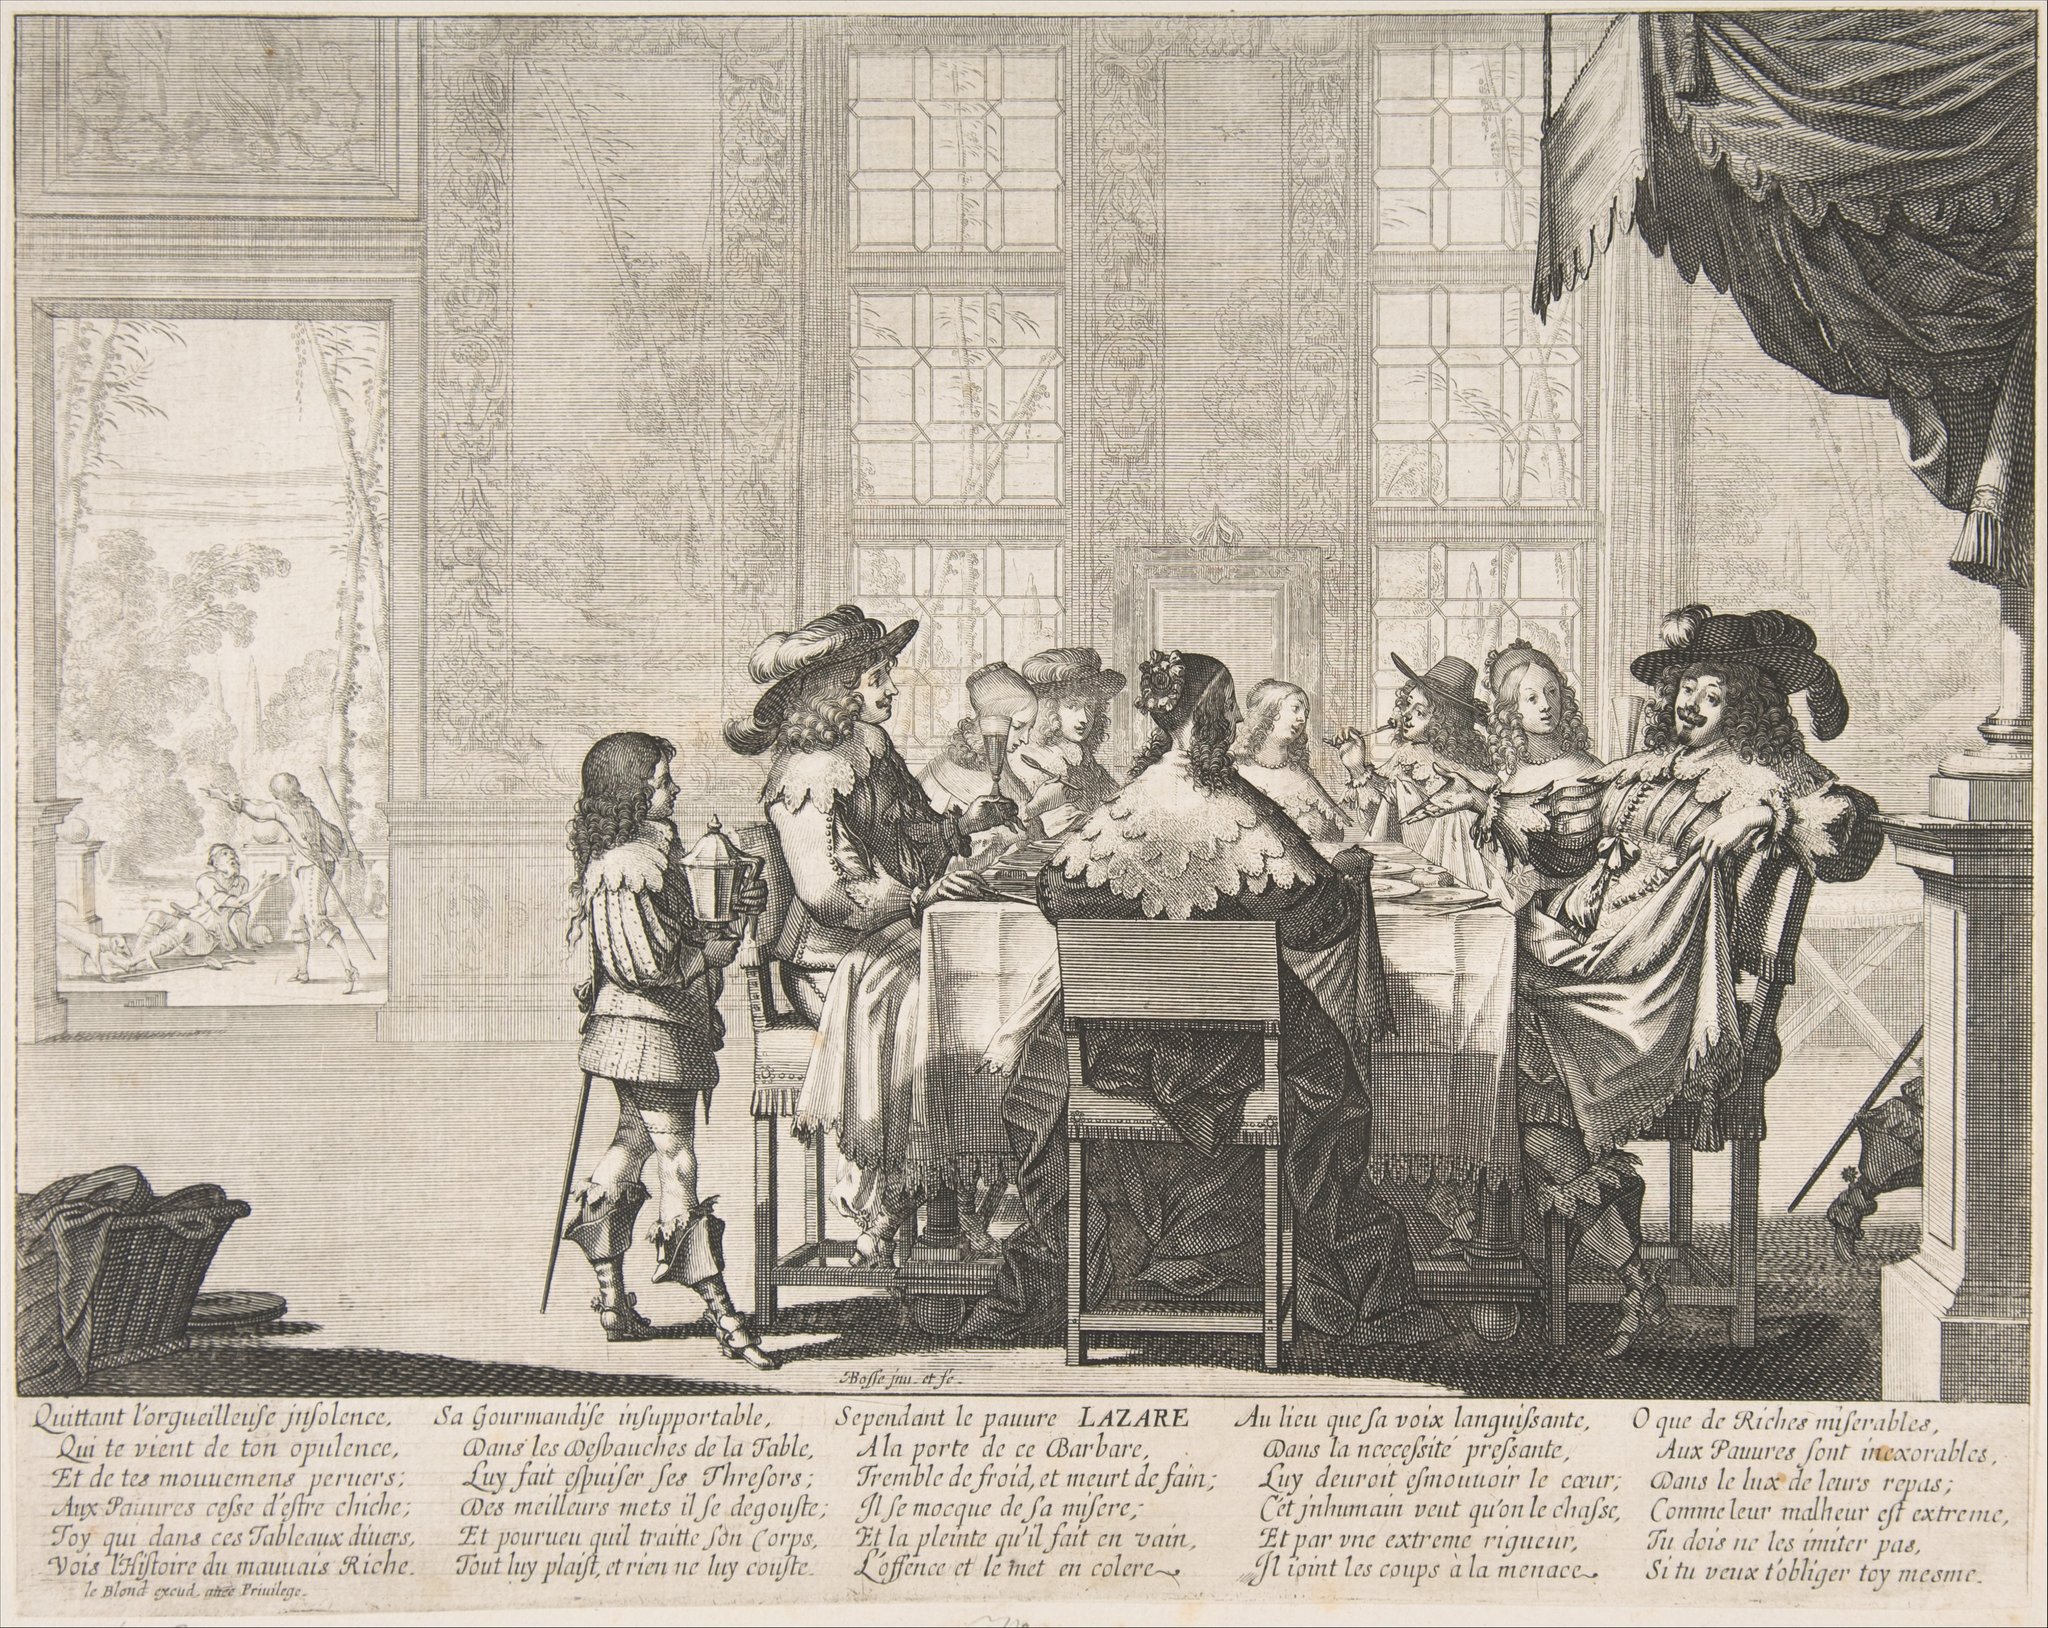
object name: print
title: The Banquet of the Rich Man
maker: abraham bosse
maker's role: artist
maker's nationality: french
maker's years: 1602-1676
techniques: etching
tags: interiors,boys,men,women,dining